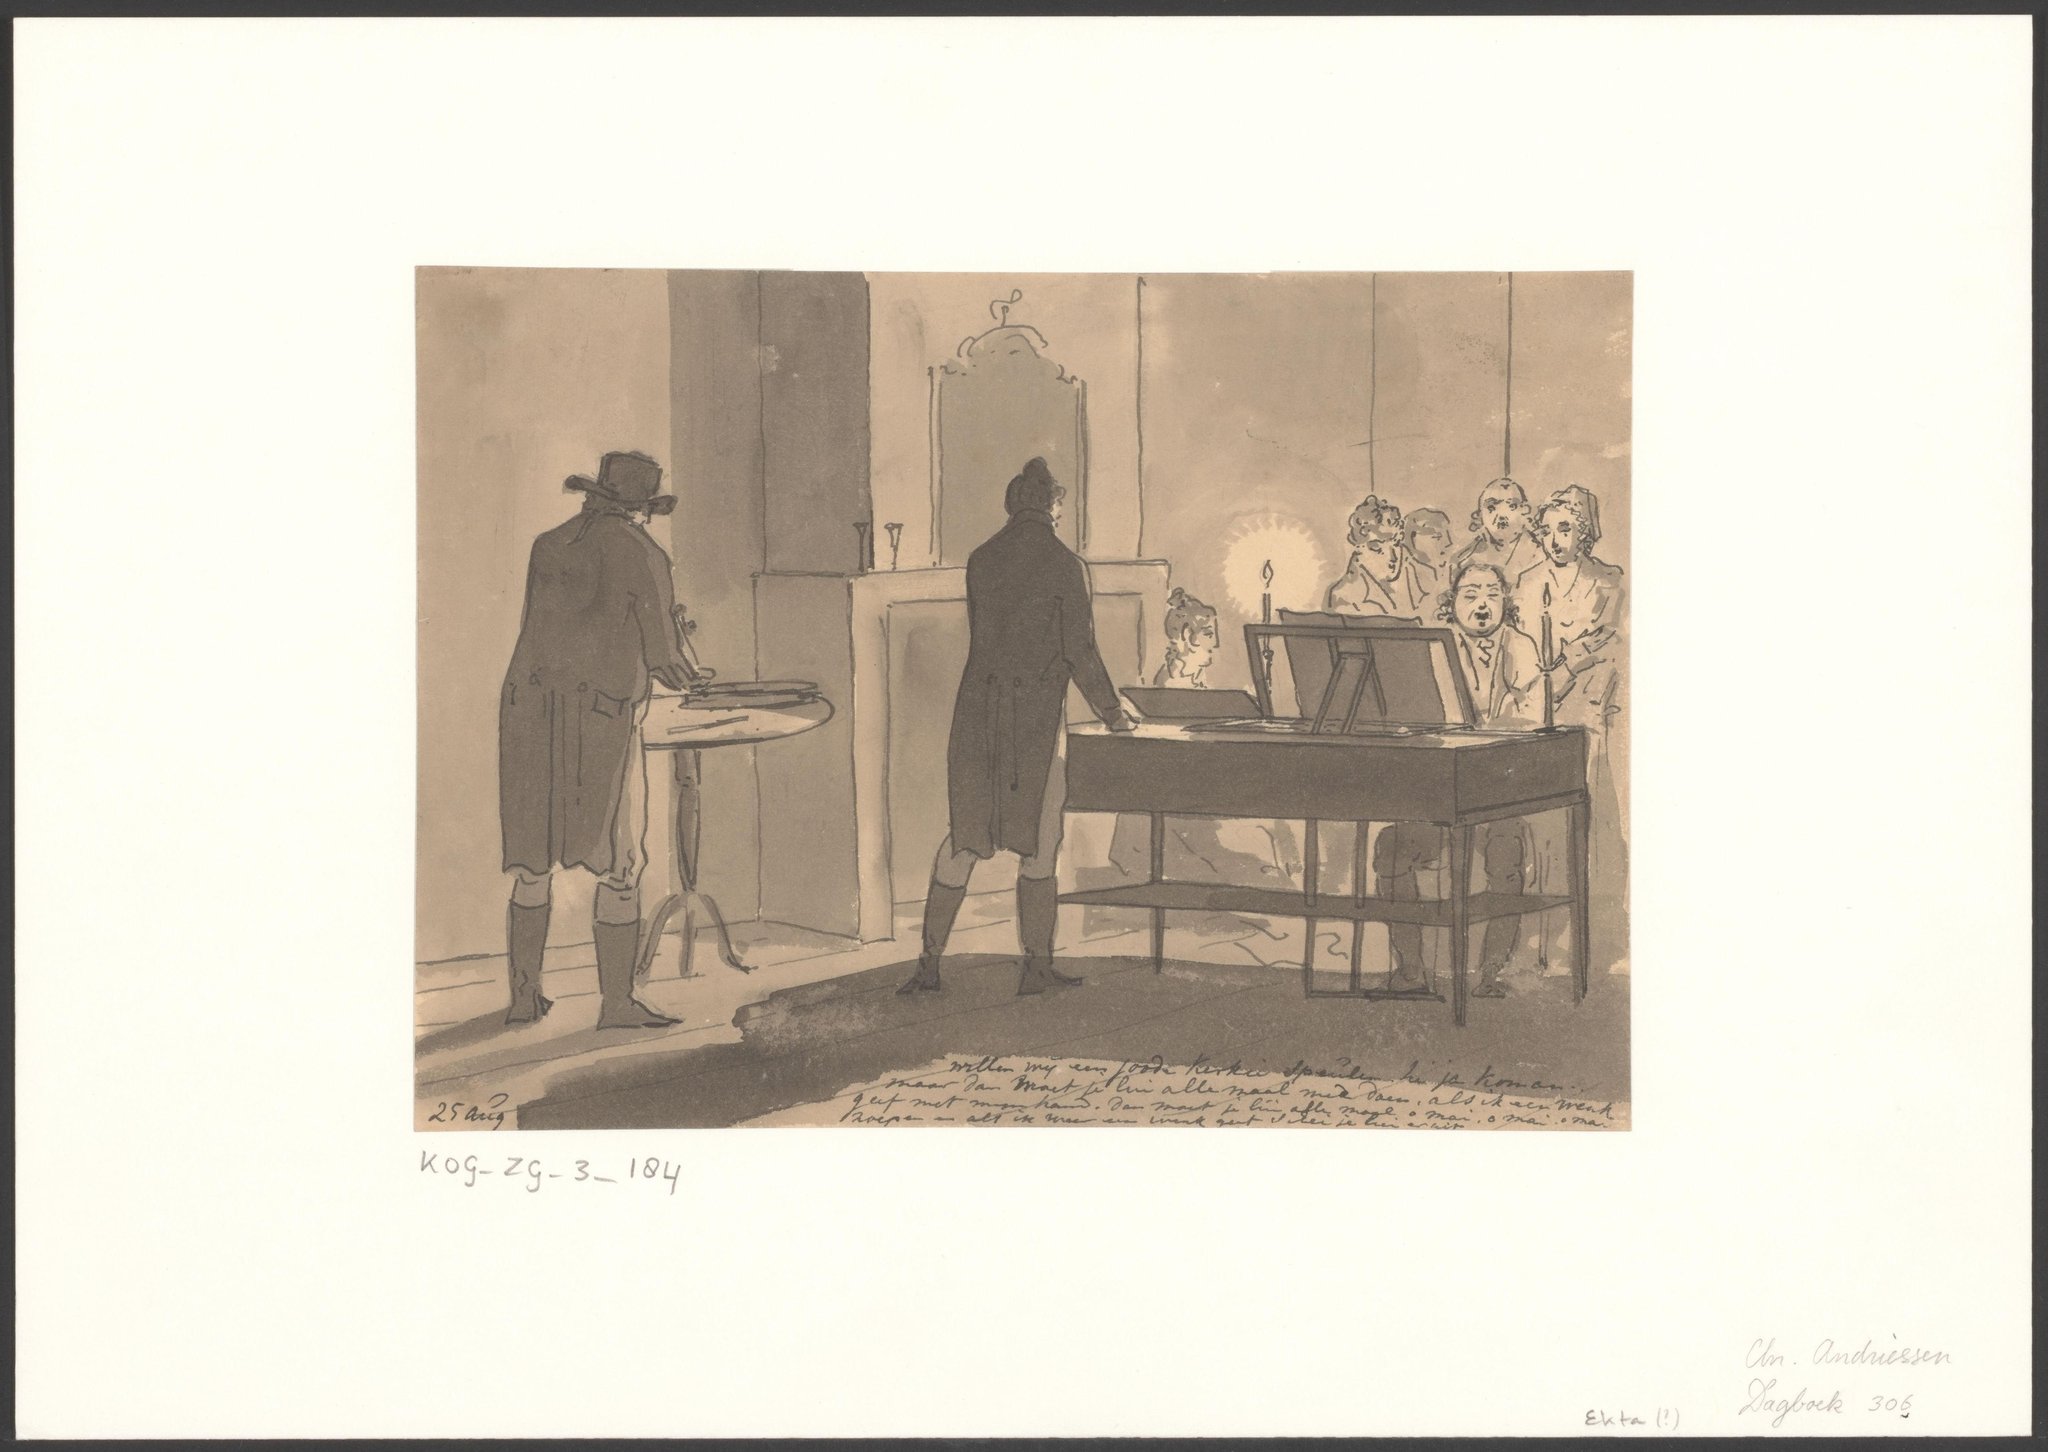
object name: drawing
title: Groep mensen speelt een Joodse dienst na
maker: christiaan andriessen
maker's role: draughtsman, print maker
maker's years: 1775-1846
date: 1805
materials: ink, paper, pencil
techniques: brush, pen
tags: amsterdam, print maker, draughtsman, christiaan andriessen, candle, pianoforte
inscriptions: signature: ‘J Andriessen’, inscription: ‘25 Aug willen wij een joods kerkie speulen (...)’, collector's mark: Lugt 1641a, collector's mark: Lugt 1641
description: Dagboekblad uit het getekende dagboek dat Christiaan Andriessen bijhield van 1805 tot en met 1808.